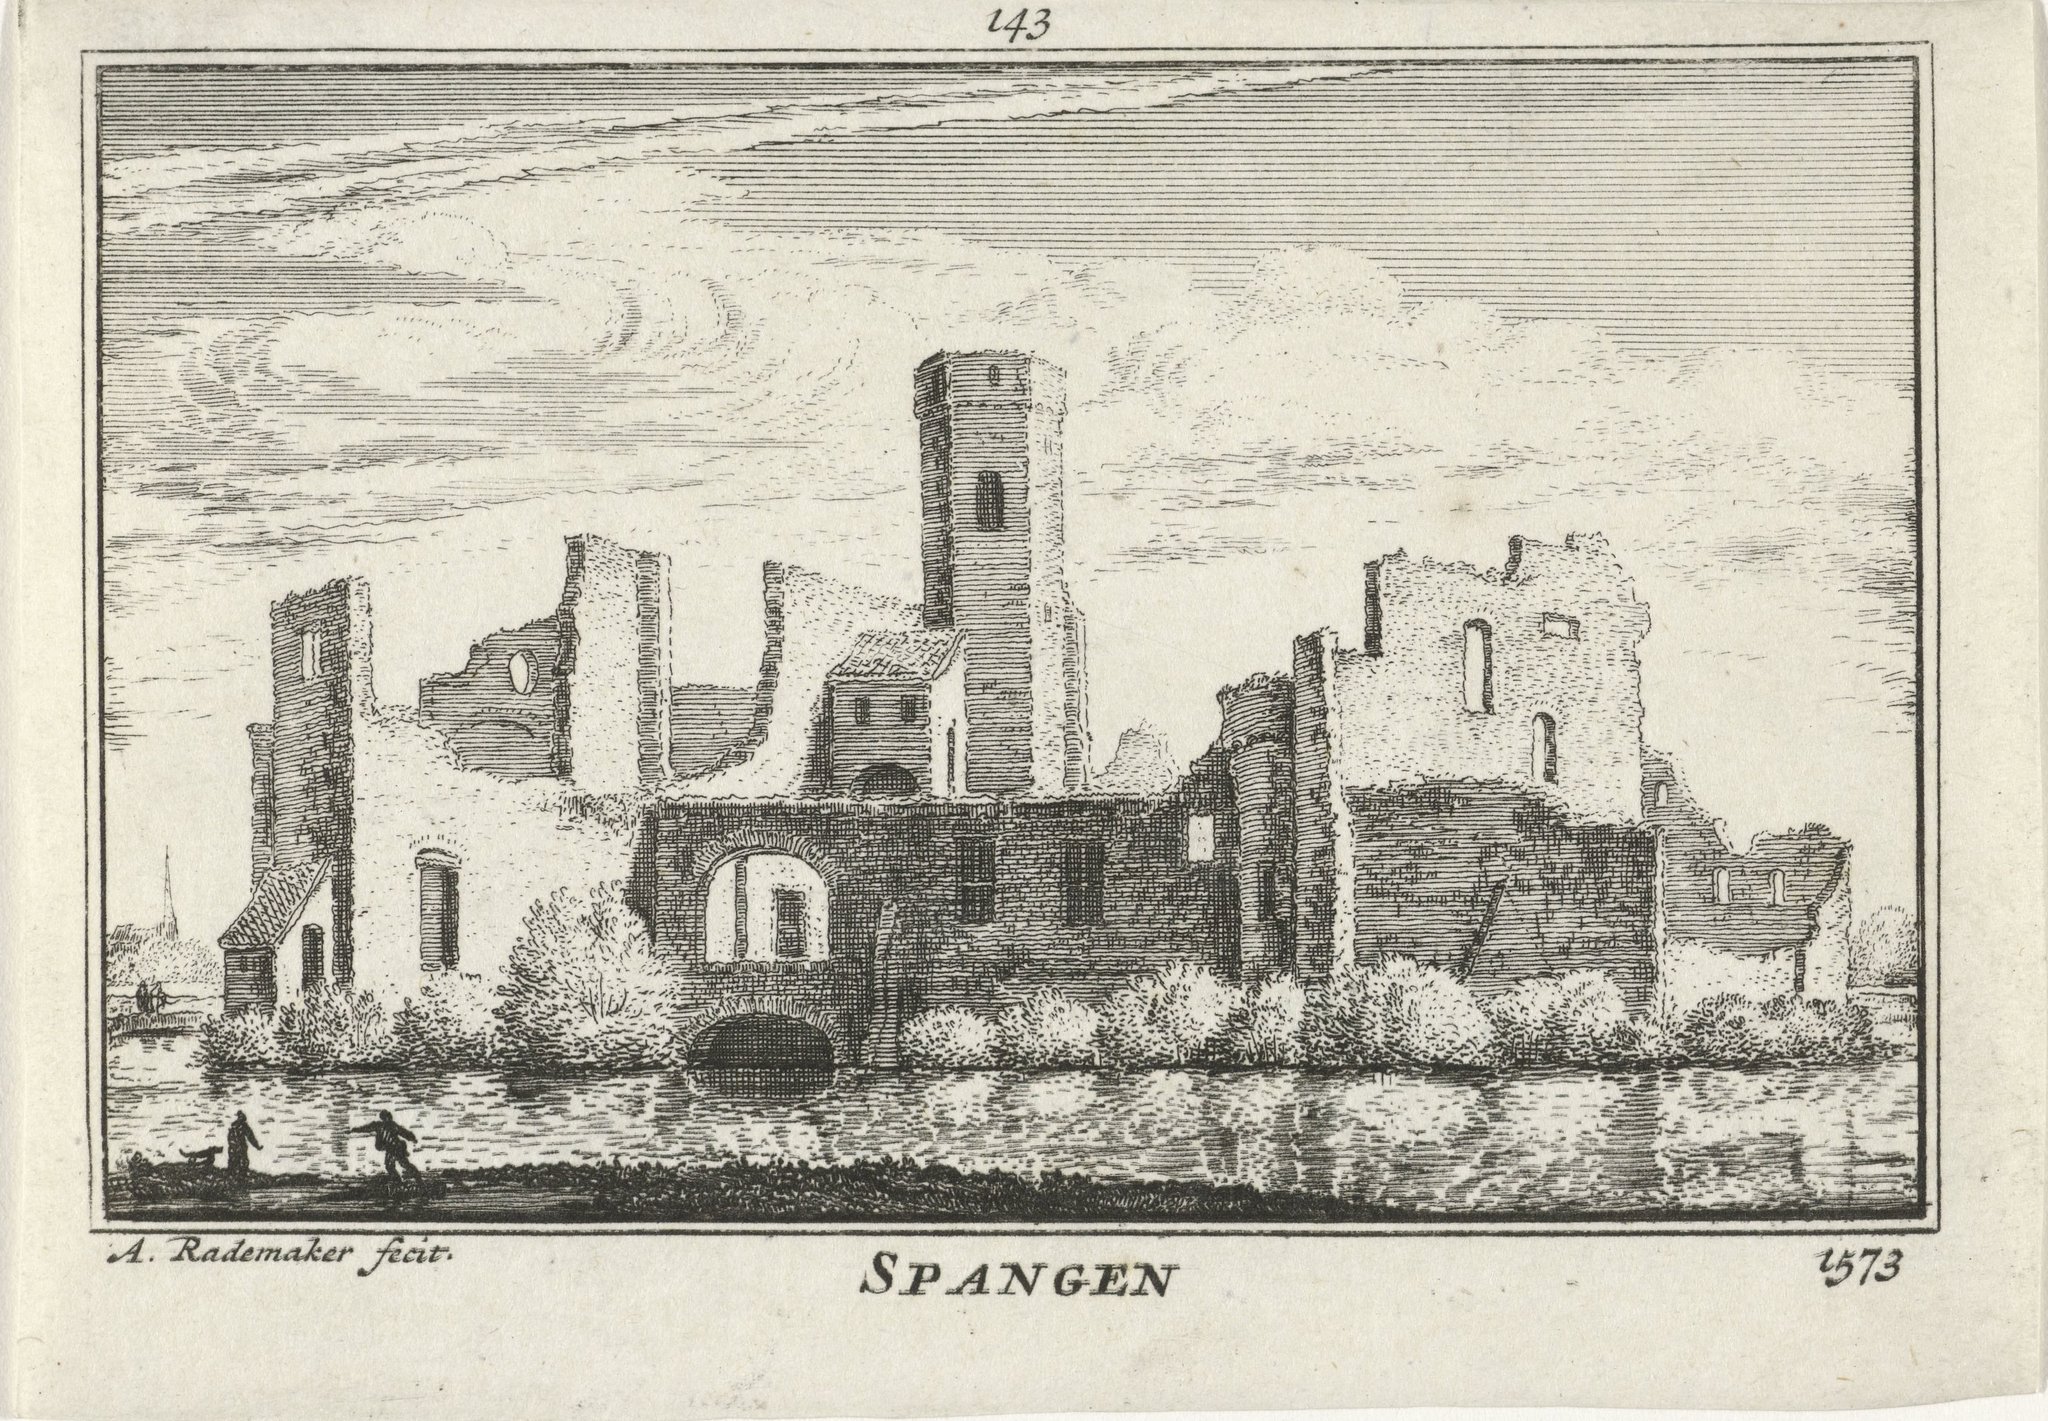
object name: print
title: Spangen 1573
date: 1727-1733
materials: paper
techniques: etching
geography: amsterdam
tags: ruin of a dwelling, house, castle, etc., dog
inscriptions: collector's mark: Lugt 2228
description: Illustratie uit: Abraham Rademaker, Matthaeus Brouërius van Niedek, Isaac Le Long, Kabinet van Nederlandsche en Kleefsche outheden en (...) voorname stads- en landgebouwen, Willem Barents en Antoni Schoonenburg: Amsterdam, 1727-1733, ill. nr. 143.